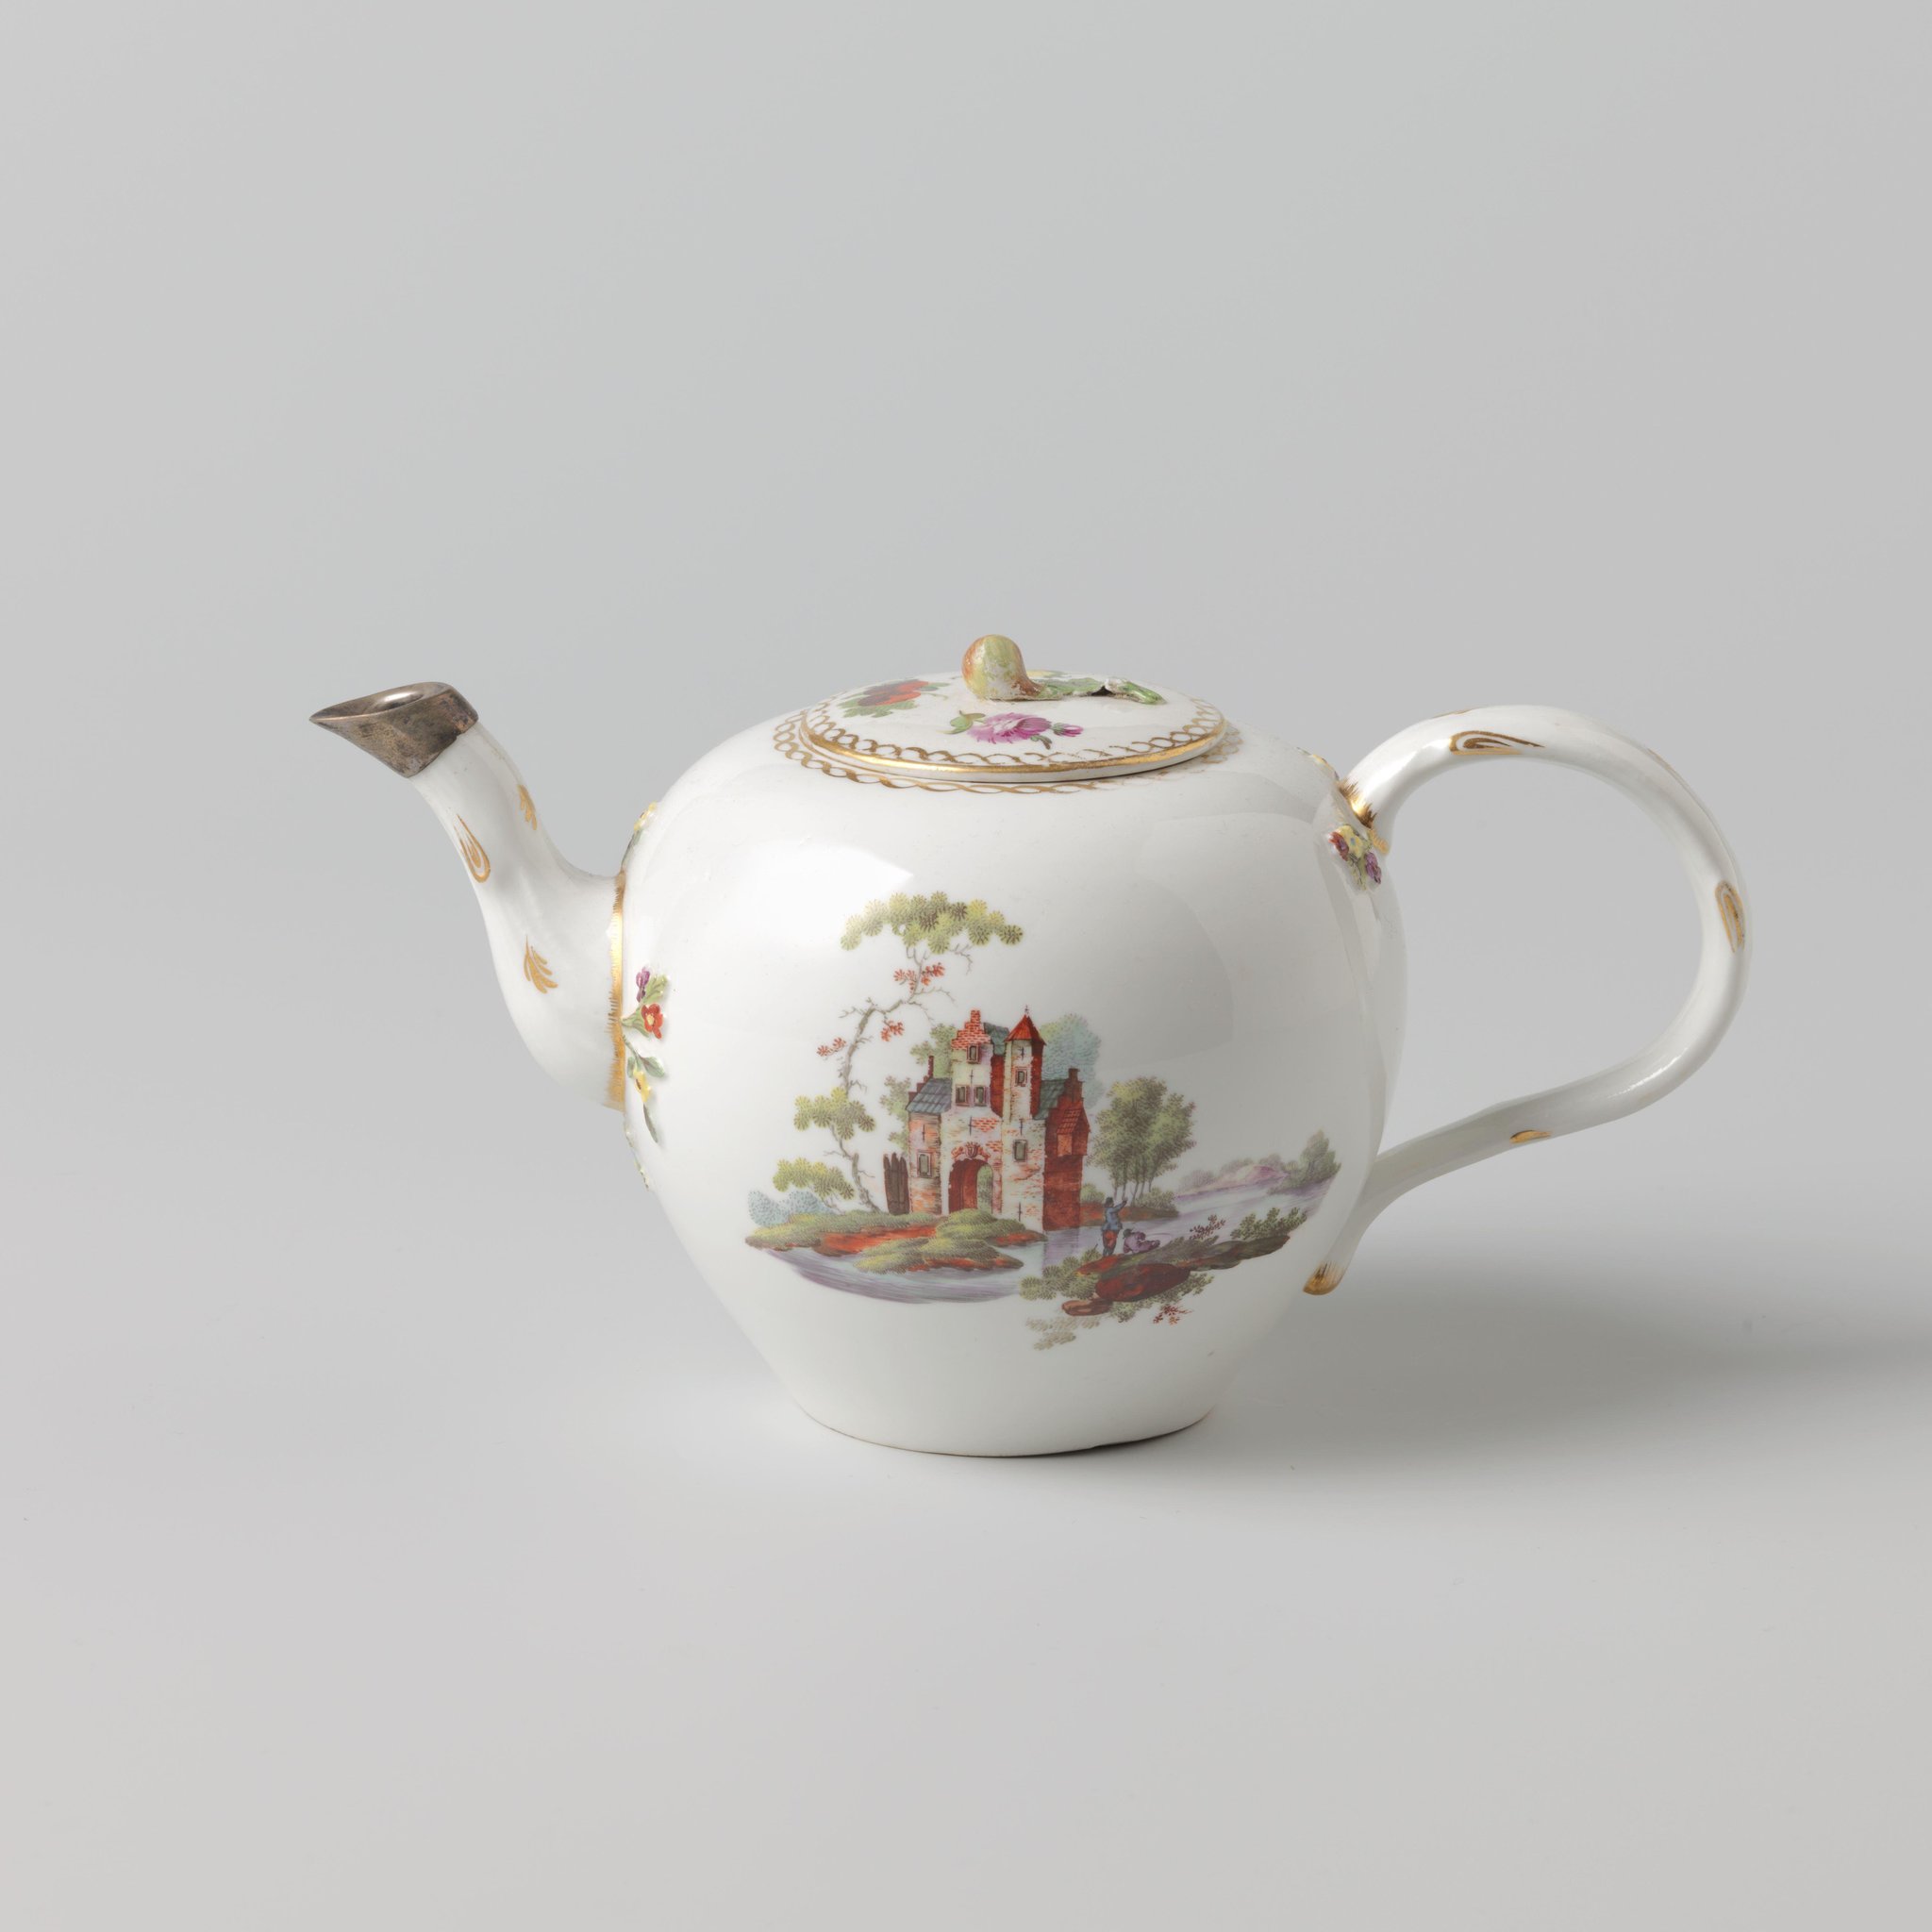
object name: teapot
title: Theepot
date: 1777-1790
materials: porcelain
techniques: painted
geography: the hague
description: Deksel van theepot de knop in de vorm van een vrucht en beschilderd met bloemen.